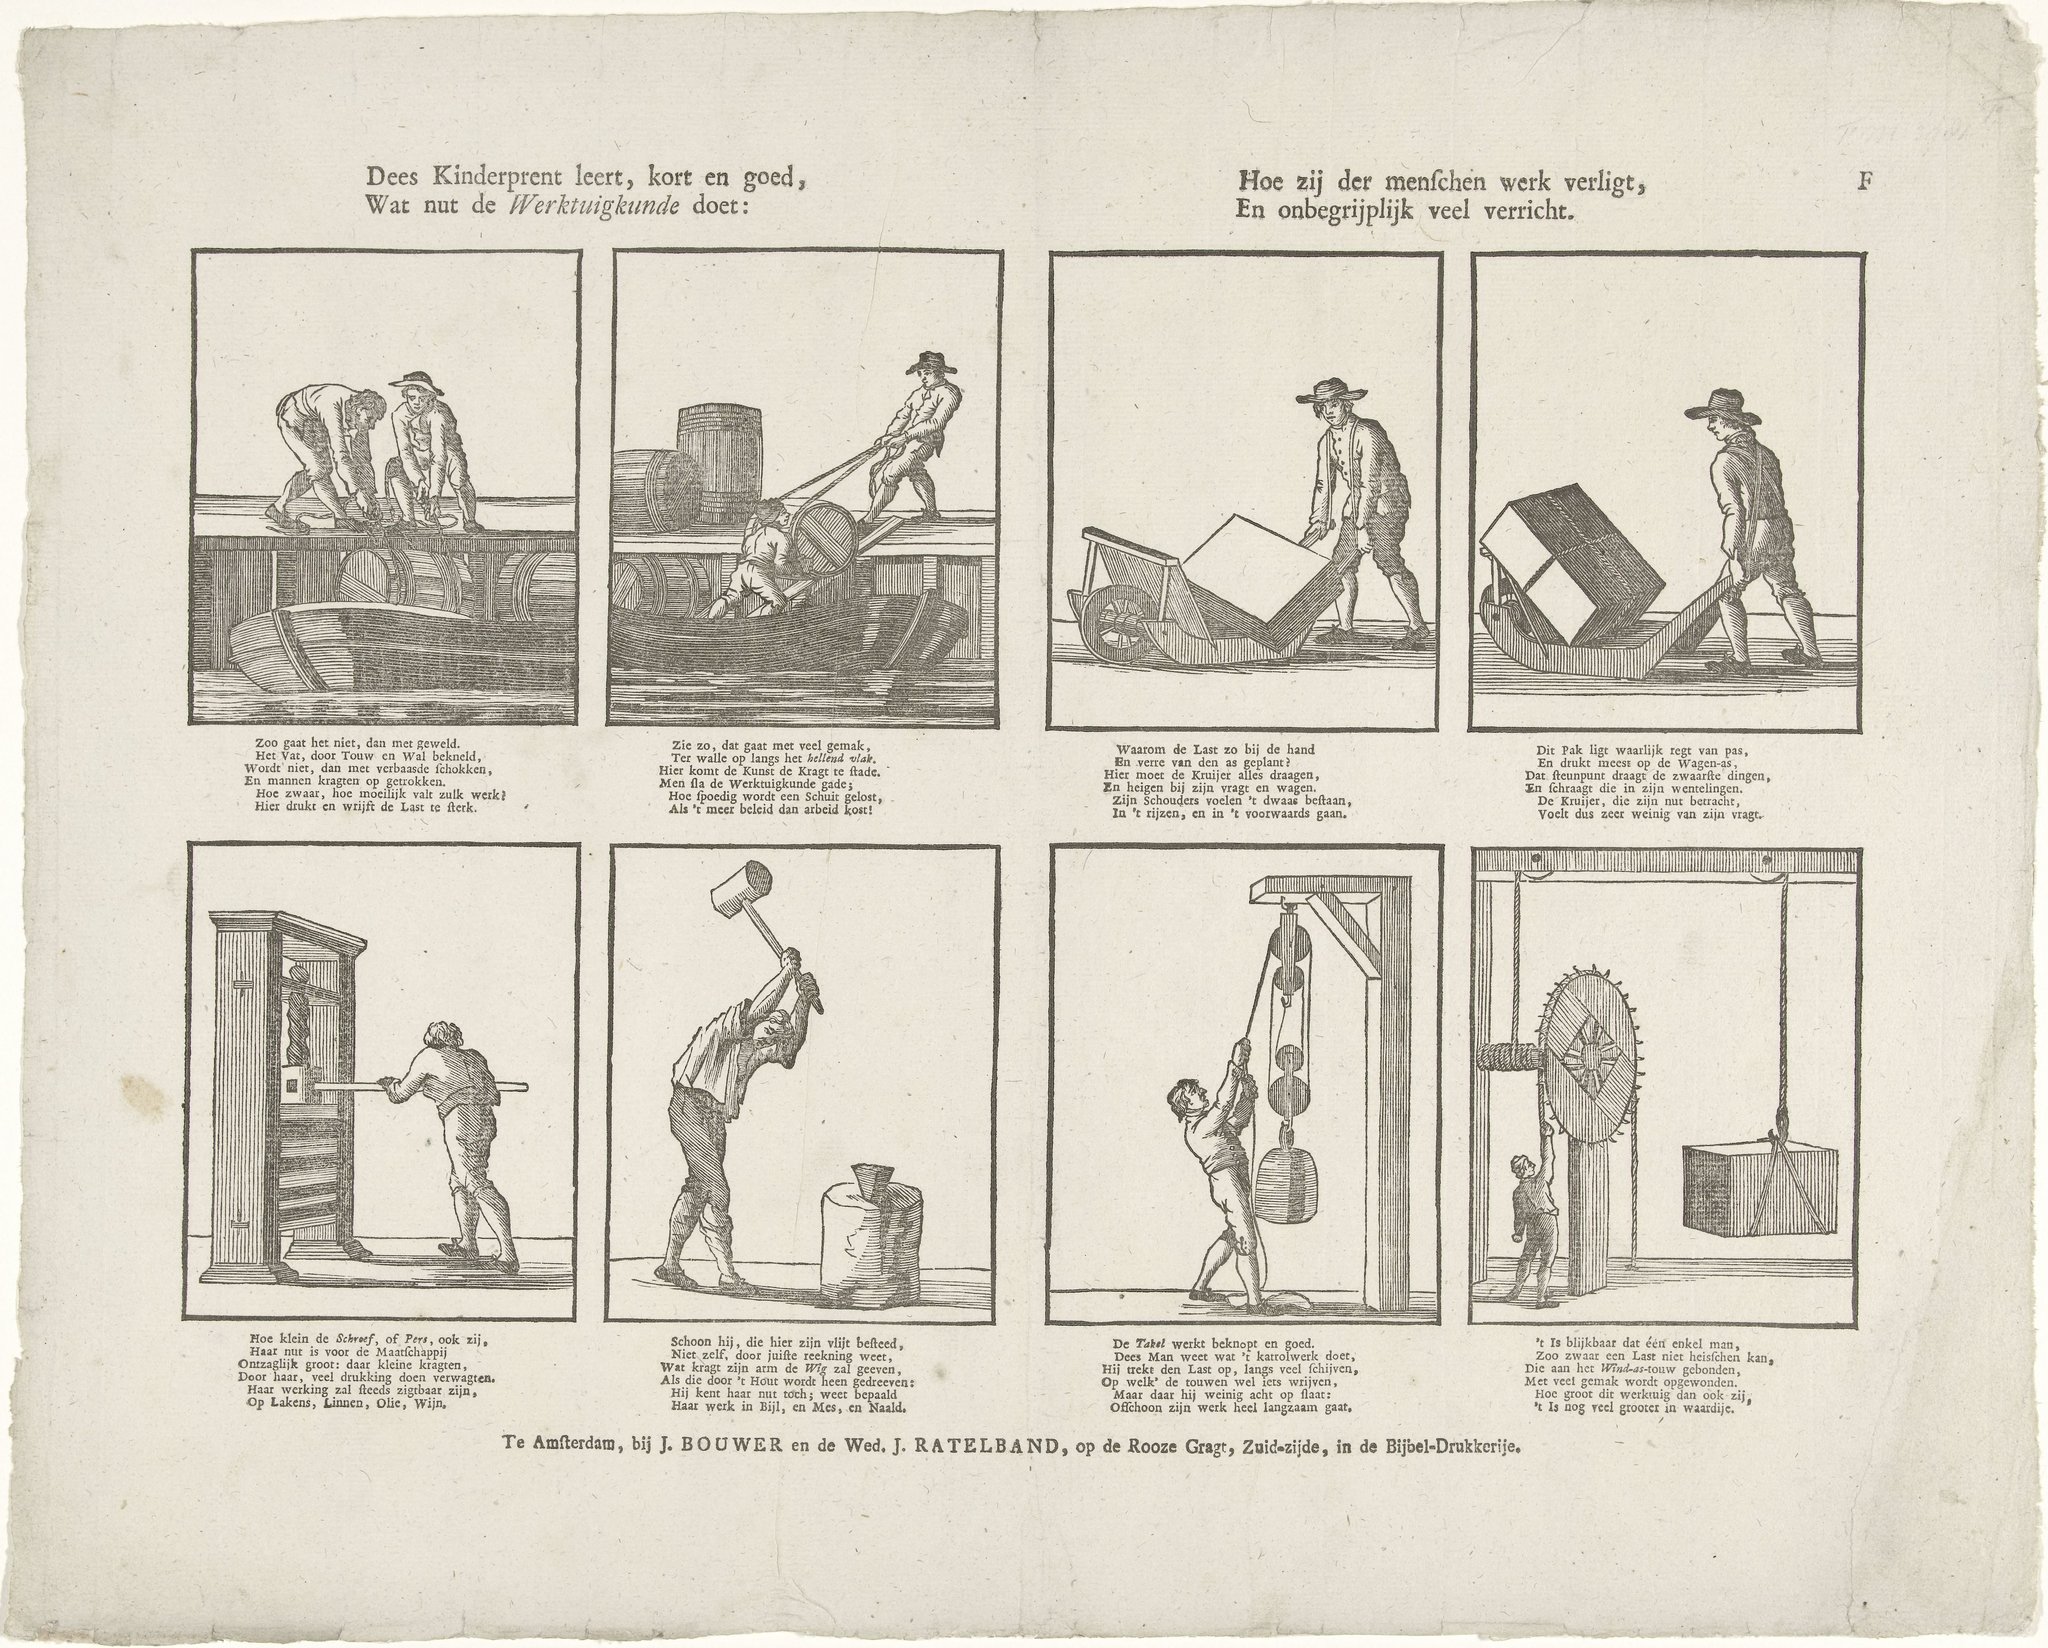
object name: popular print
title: Dees kinderprent leert, kort en goed, / Wat nut de werktuigkunde doet: / Hoe zij der menschen werk verligt, / En onbegrijplijk veel verricht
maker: Anonymous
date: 1794-1804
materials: paper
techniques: letterpress printing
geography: netherlands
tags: tools and machines ~ building, dynamics, kinetics, printing press, dock crane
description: Blad met 8 voorstellingen van mannen die werktuigen gebruiken, zoals een pers en een hijskraan. Onder elke afbeelding een zesregelig vers. Genummerd rechtsboven: F.